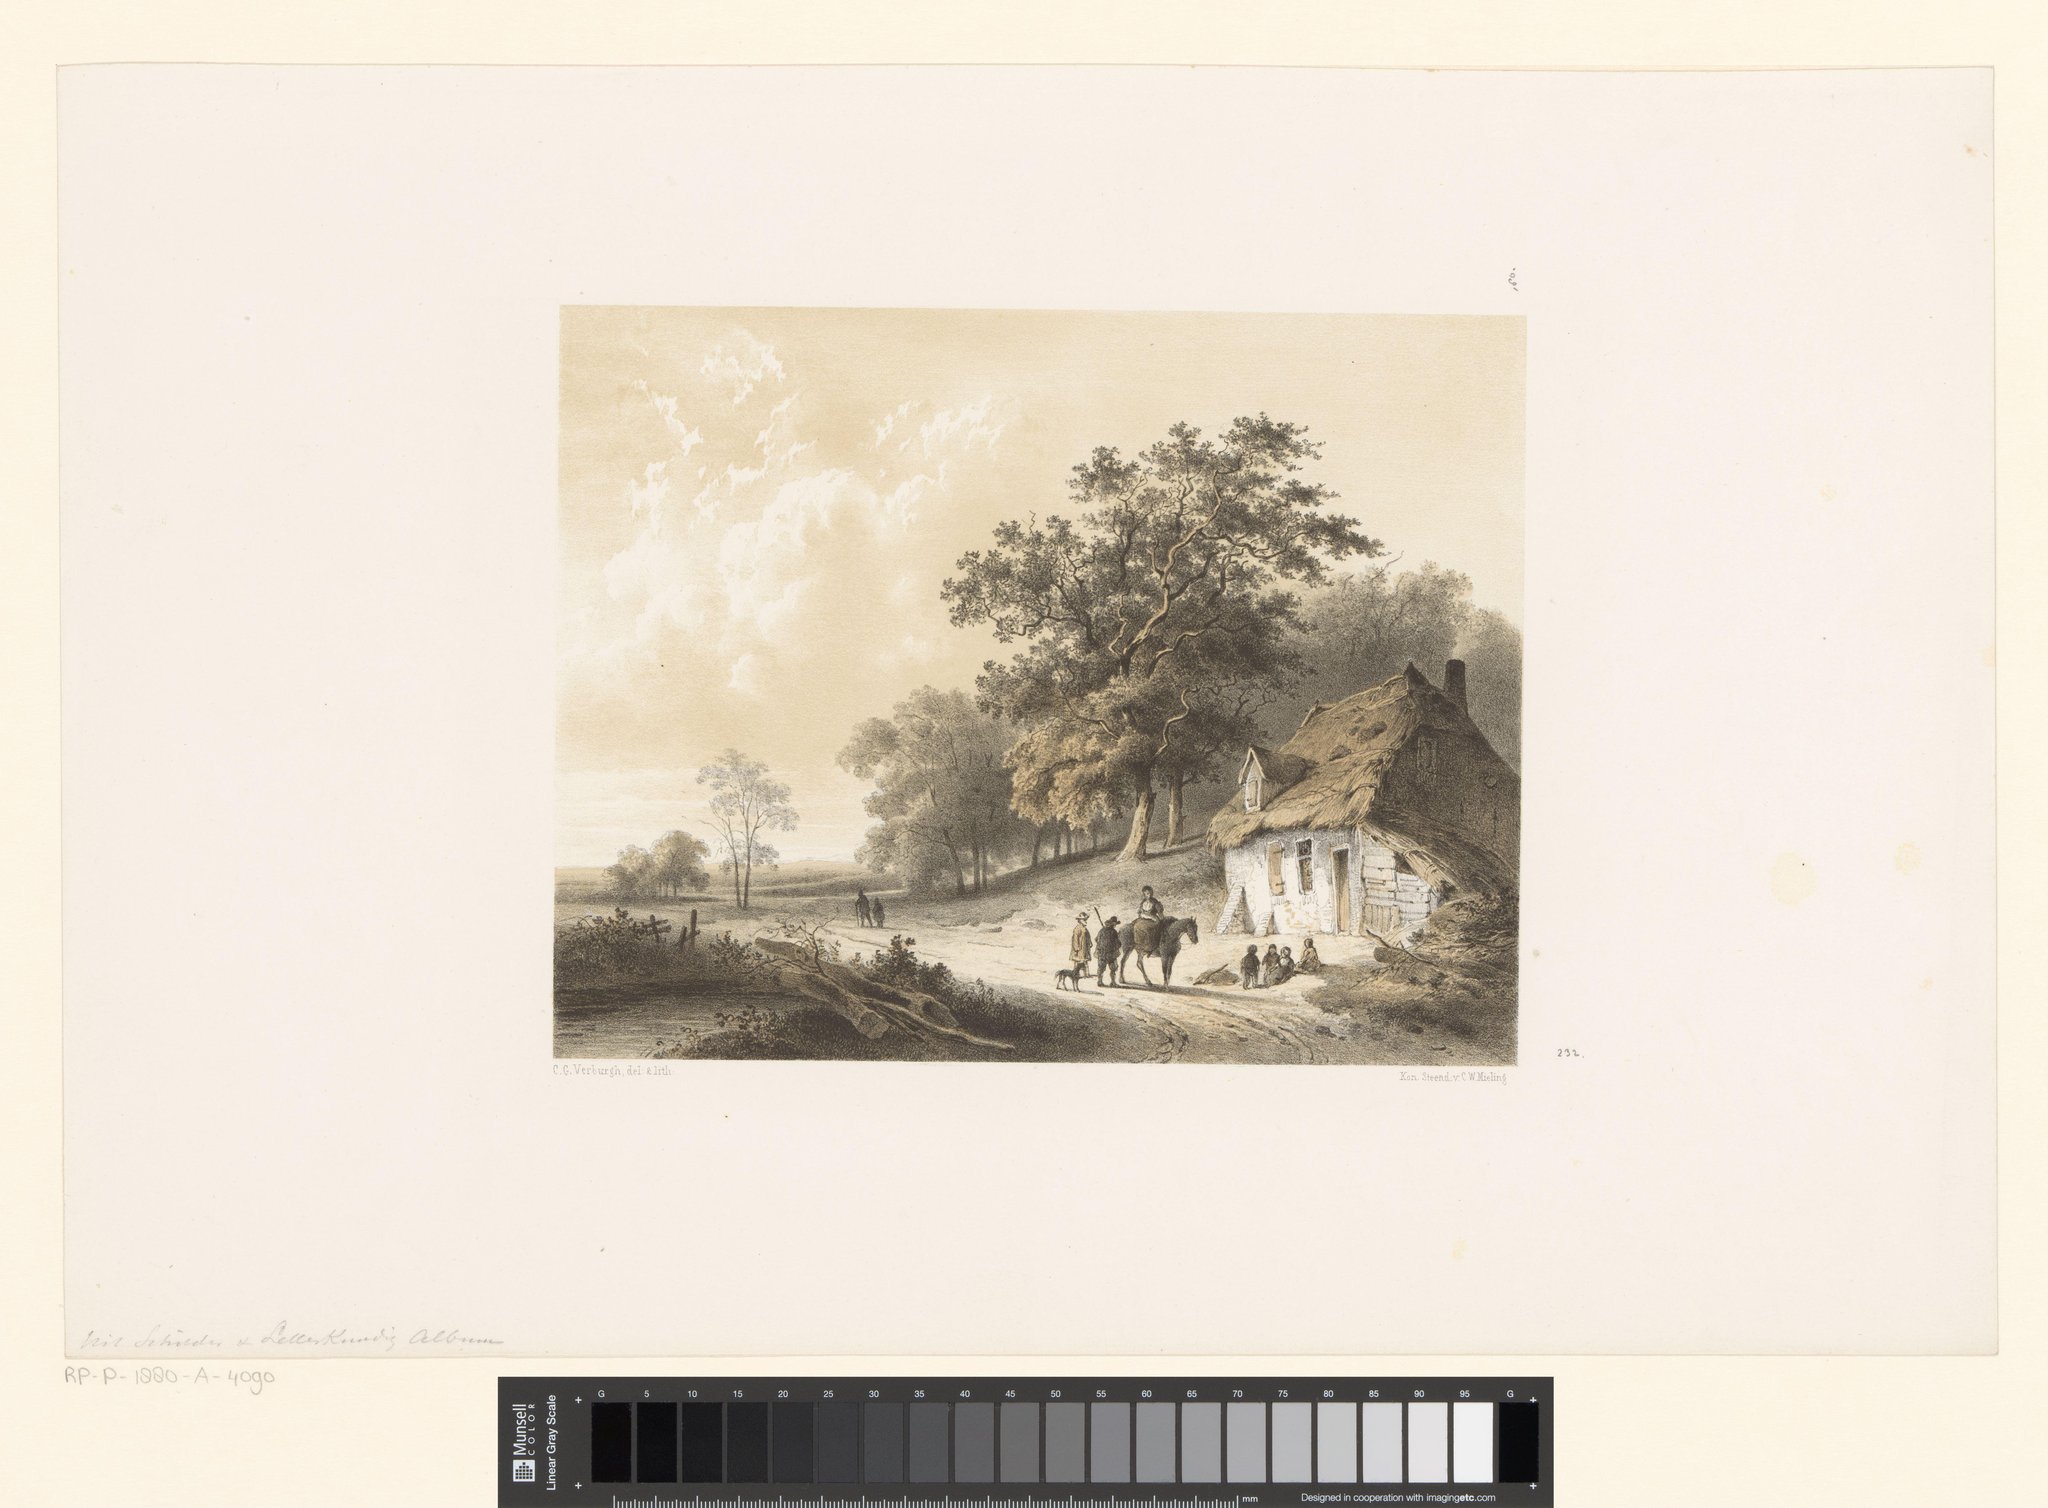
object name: print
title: Landschap met woning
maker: cornelis gerrit verburgh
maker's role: print maker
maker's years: 1802-1879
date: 1847-1865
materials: paper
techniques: tone lithography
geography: the hague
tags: landscapes (+ landscape with figures, staffage)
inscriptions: collector's mark: Lugt 2228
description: Vier kinderen zitten voor in een landschap voor een woning. Op het pad voor hen zit een vrouw op een paard, zij is in gesprek met twee mannen.